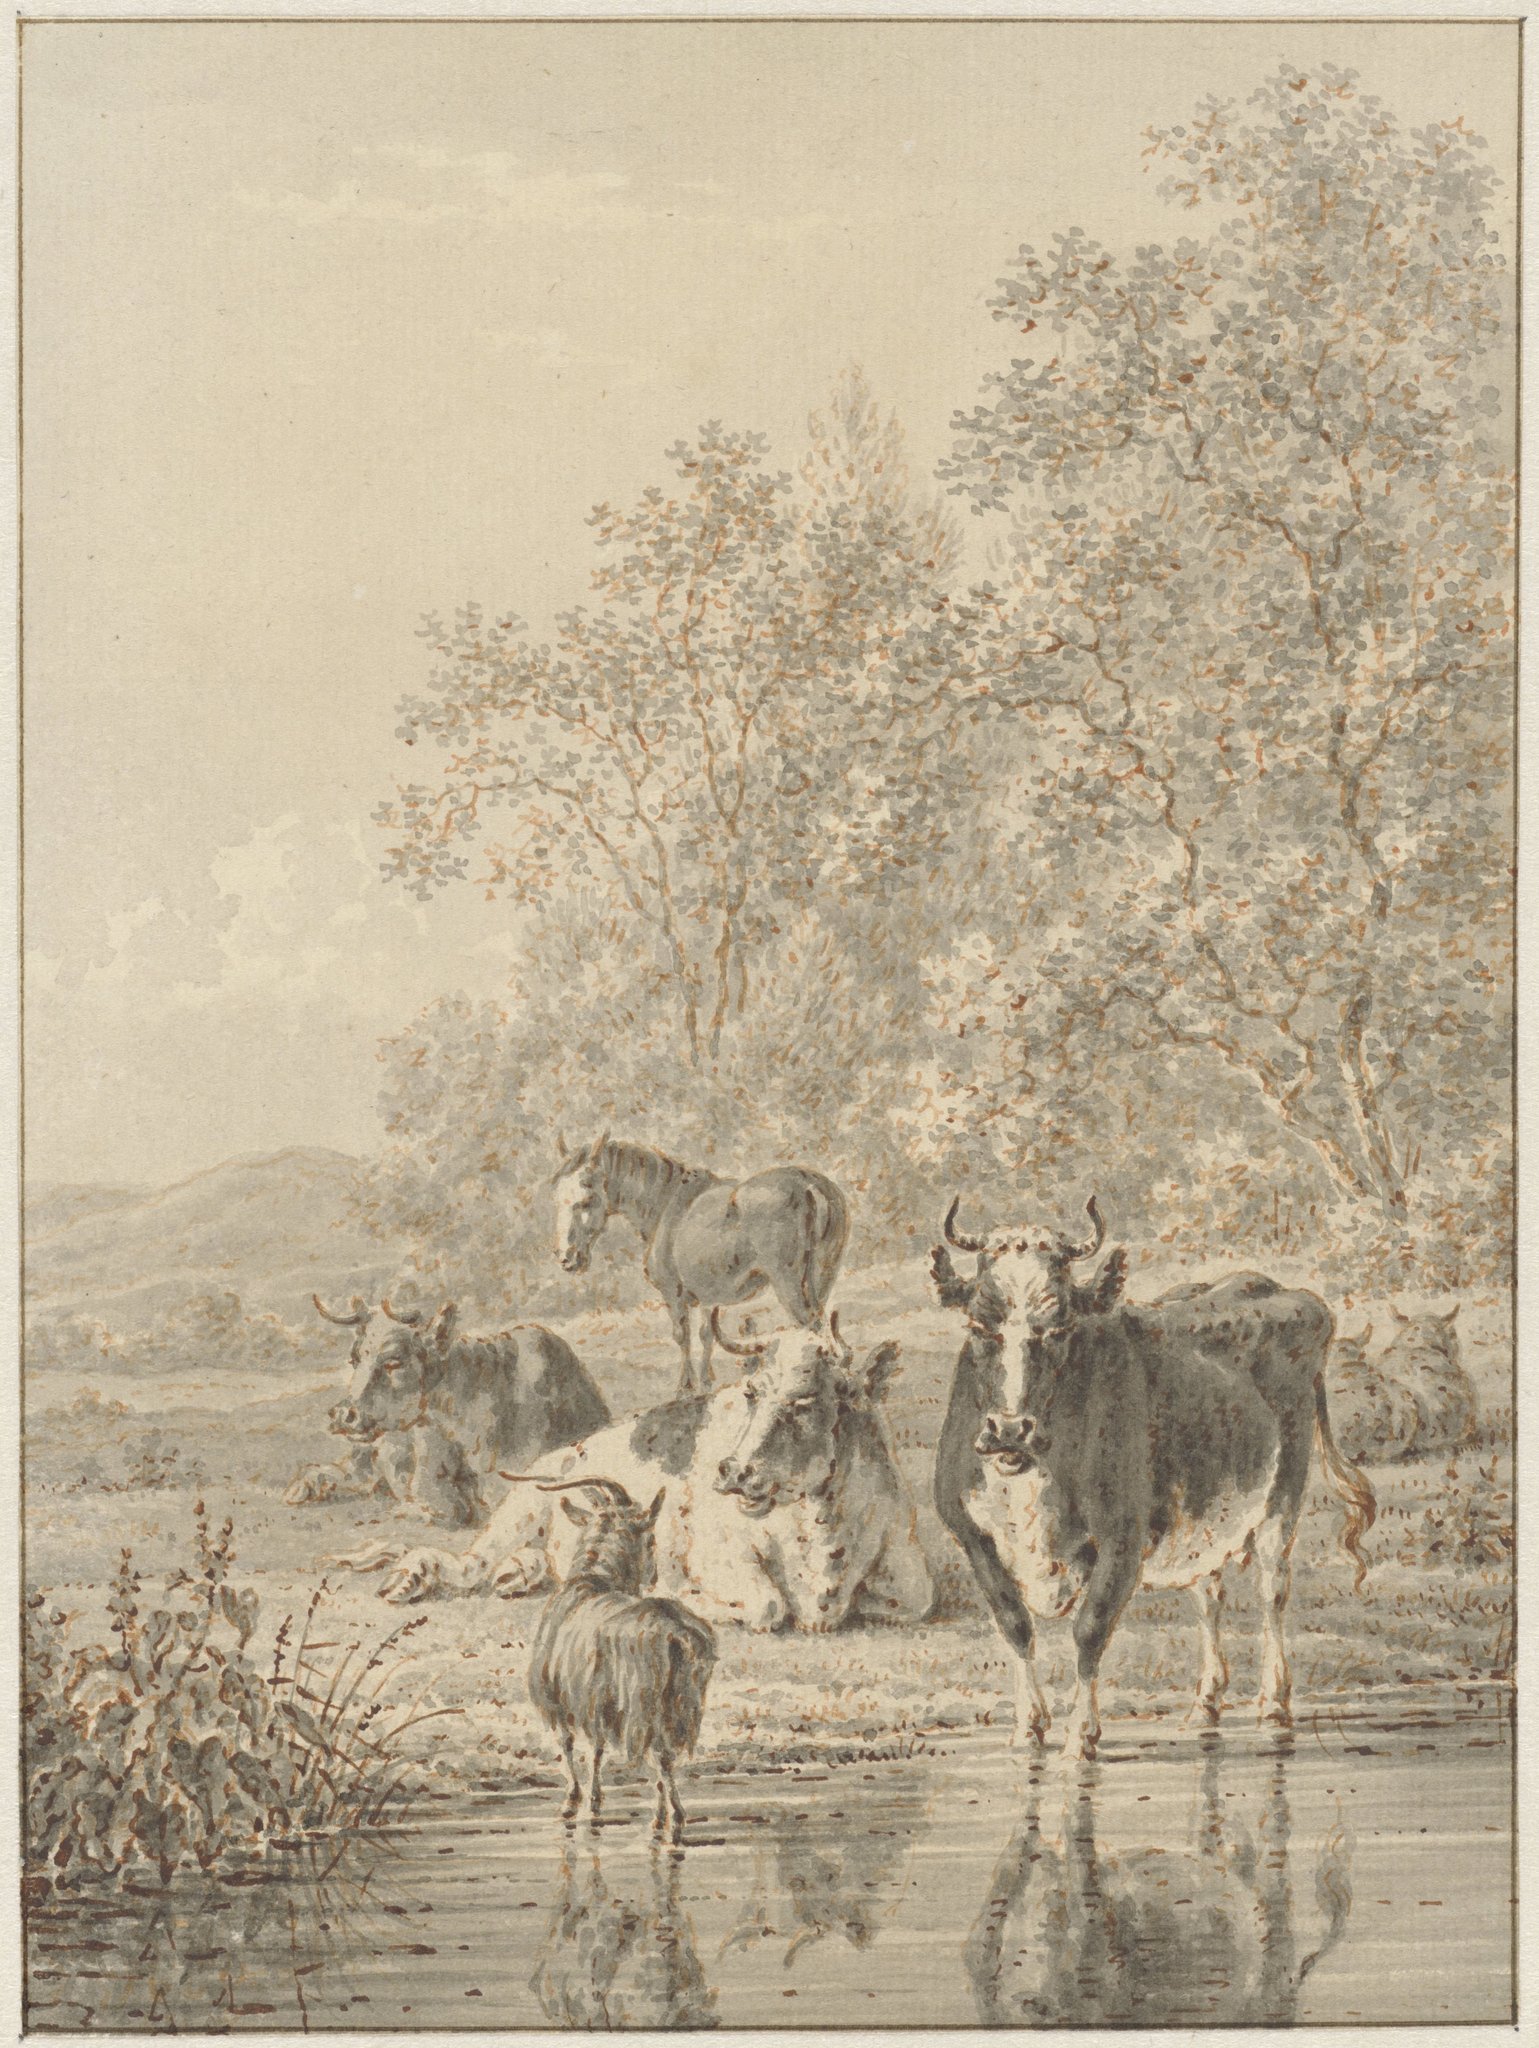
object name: drawing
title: Landschap met vee bij het water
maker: pieter de goeje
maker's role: draughtsman, print maker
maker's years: 1789-1859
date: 1789-1859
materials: ink, paper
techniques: brush, pen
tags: cattle